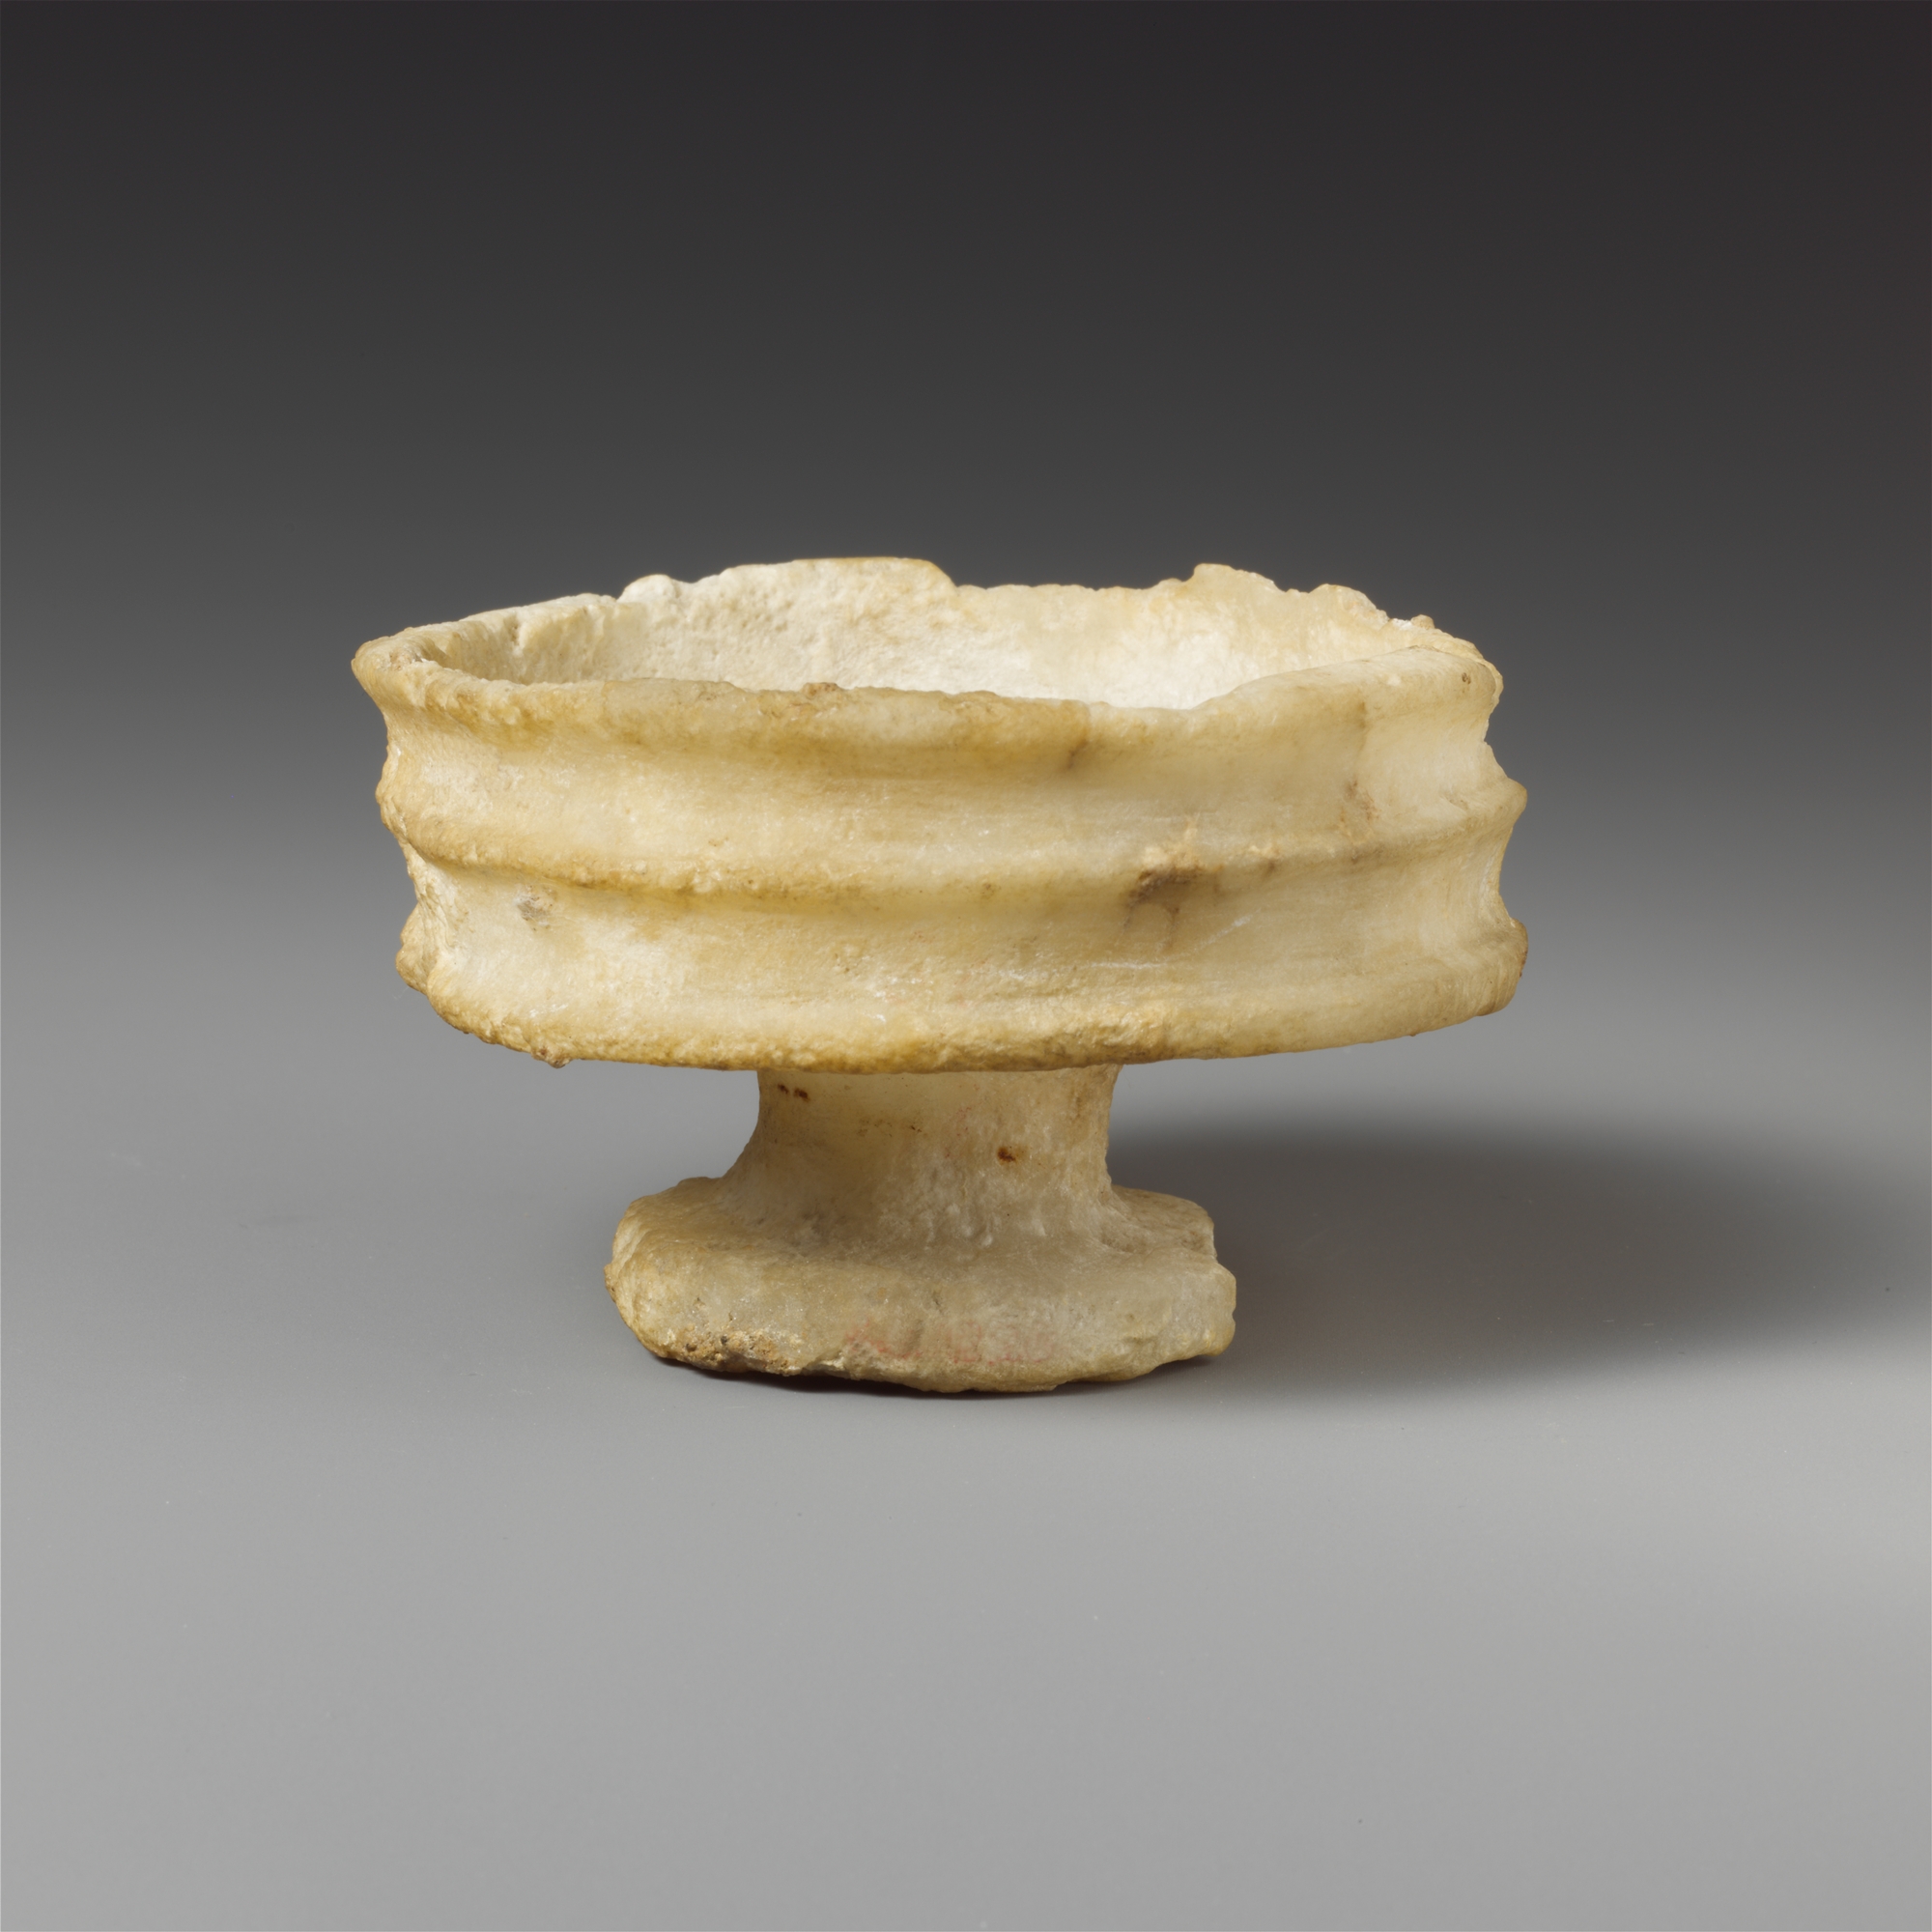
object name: bowl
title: Alabaster stemmed bowl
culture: cypriot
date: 1600-1200 BCE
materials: gypsum